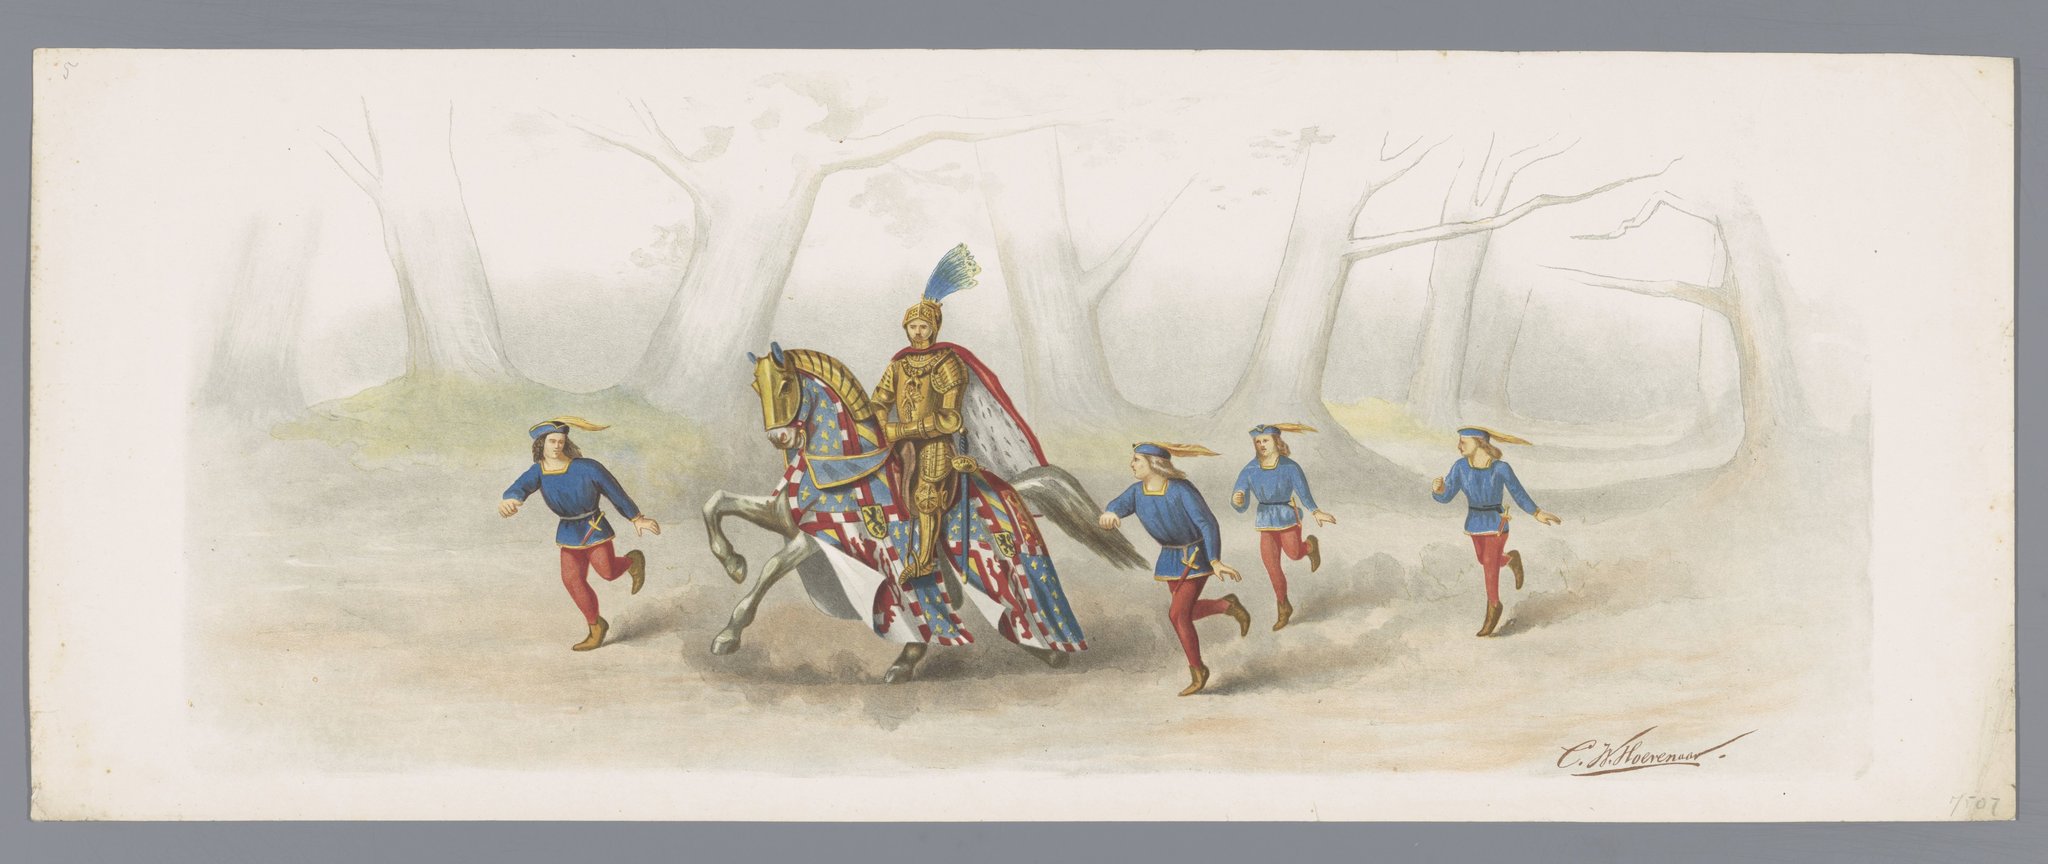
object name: print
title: XLVIII. Lustrum der Utrechtsche Hoogeschool. Intocht van Hertog Karel den Stoute te Zutfen, IV Augustus MCCCCLXXIII. Gekostumeerde optocht van Heeren Studenten, gehouden te Utrecht den 27 Juni 1876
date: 1876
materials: paper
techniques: chromolithography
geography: amsterdam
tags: earl, charles the bold (duke of burgundy), students' pageant, costumes used in pageants, commemoration of the founding of a university, utrecht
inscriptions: collector's mark: Lugt 2228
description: Vijfde deel van de optocht. Onderdeel van een serie van zeven platen plus titelprent en verklaring van de gecostumeerde optocht georganiseerd door de studenten van de Utrechtse Hogeschool ter viering van de 48e lustrum op 27 juni 1876. De optocht stelt voor de intocht van Karel te Stoute te Zutphen op 4 augustus 1473.